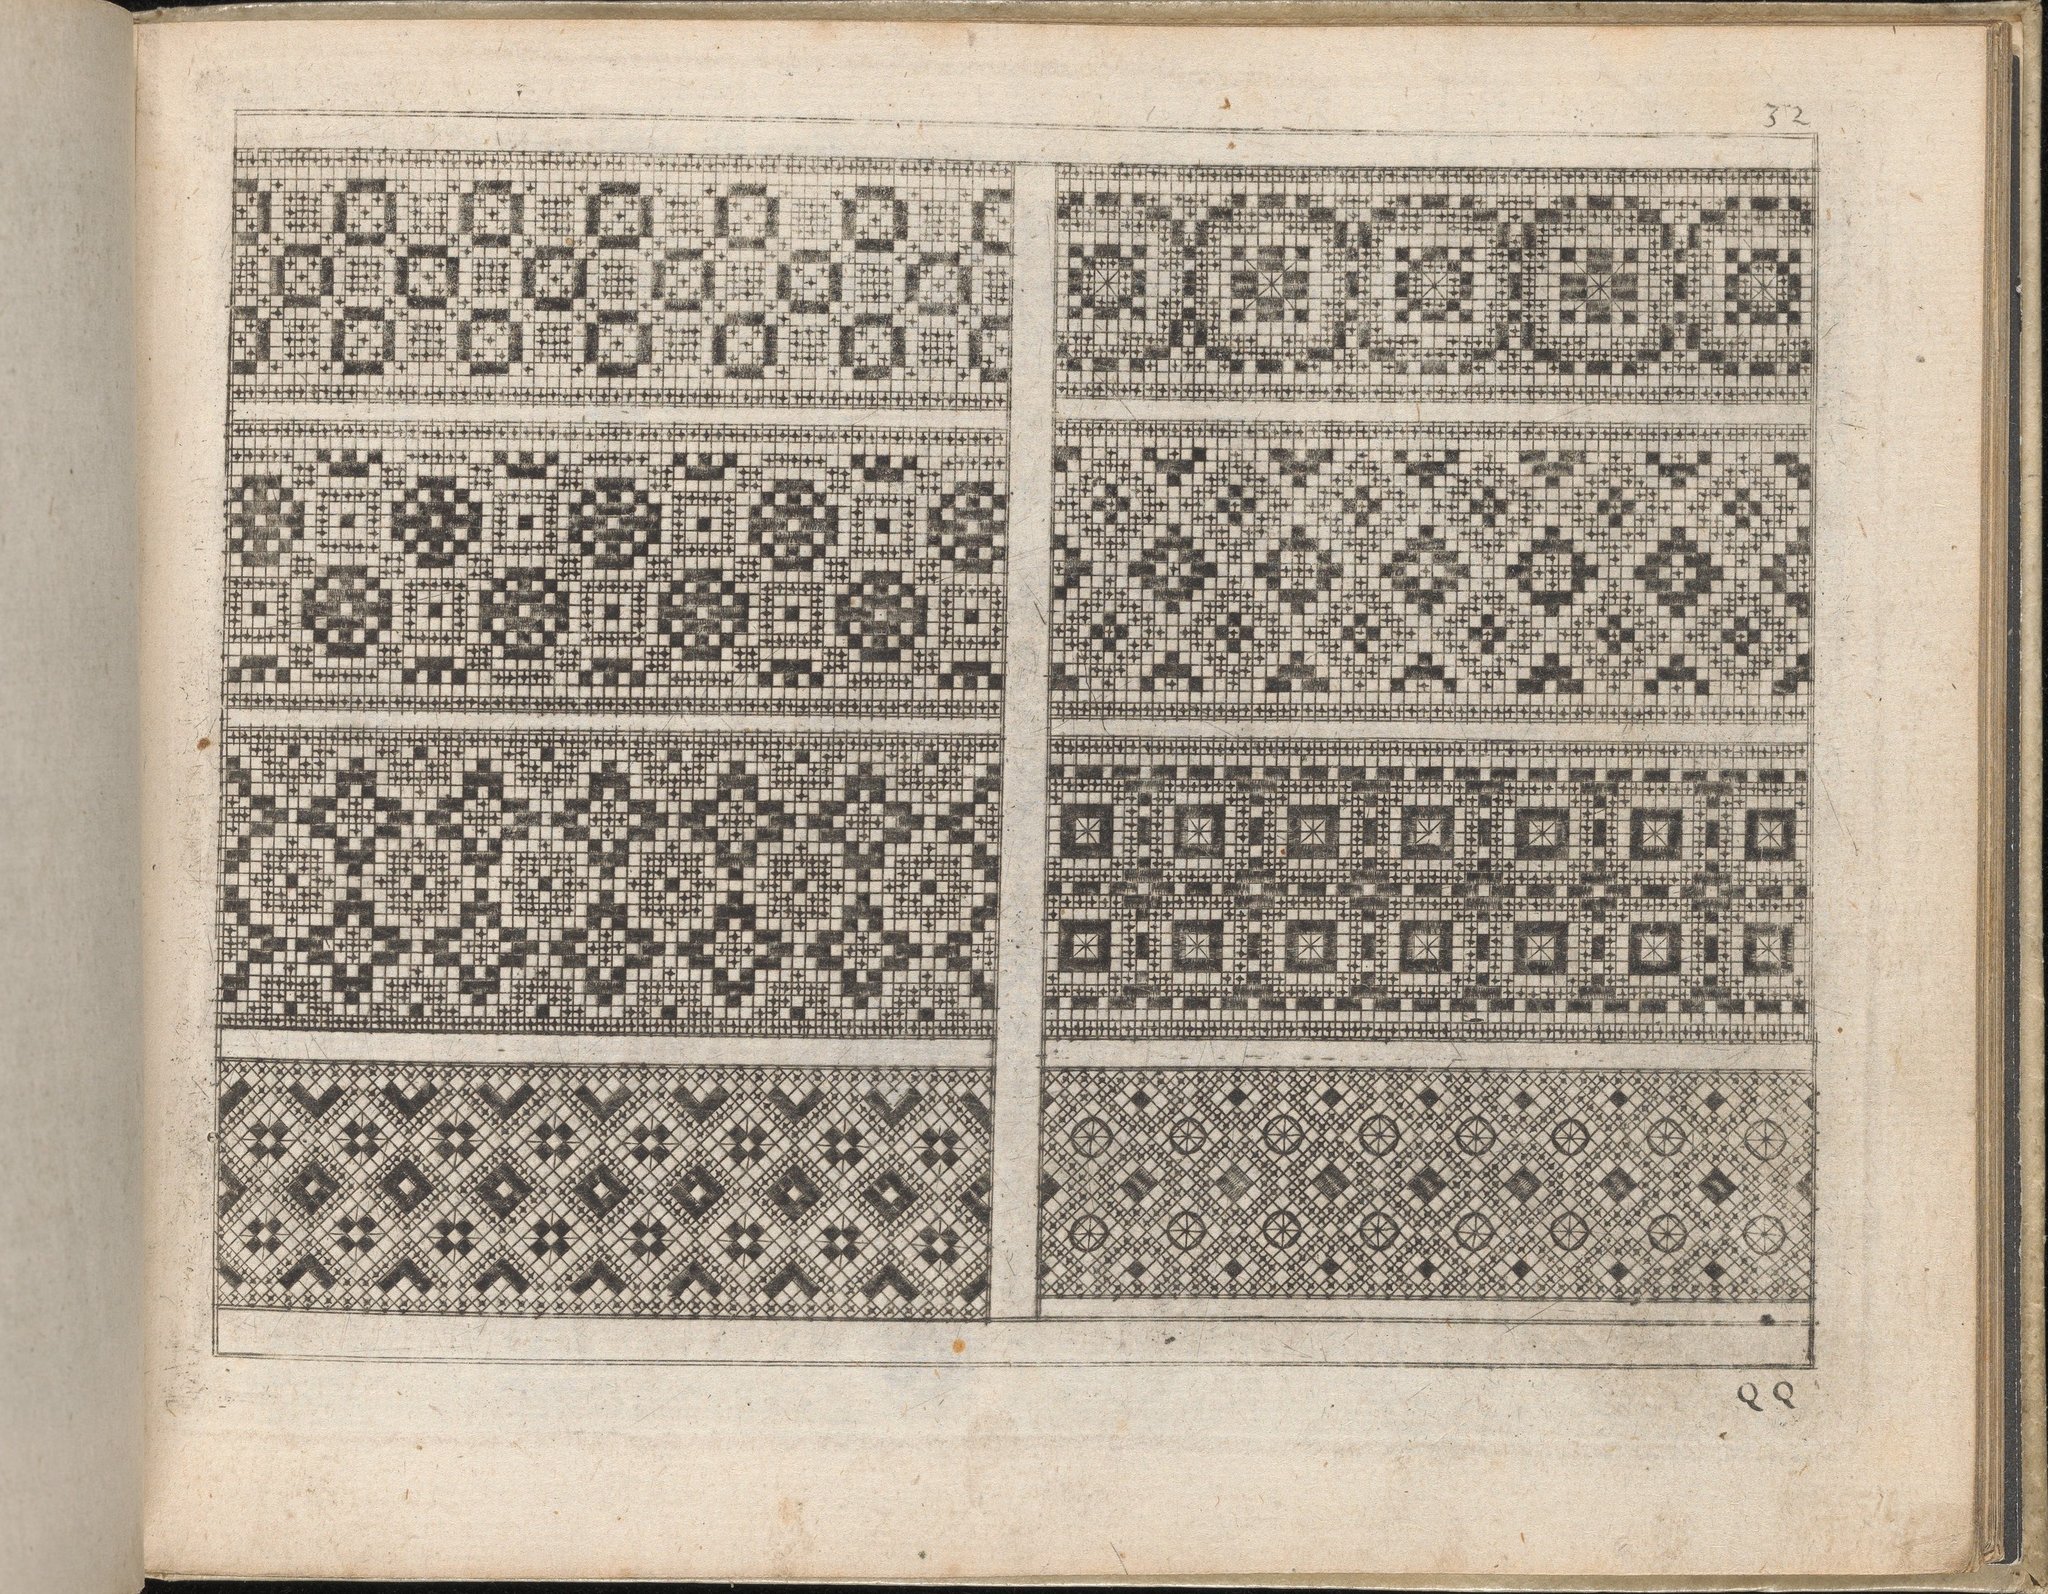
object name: book print ornament architecture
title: Newes Modelbuch in Kupffer (Page 40r)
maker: johann sibmacher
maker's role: artist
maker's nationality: german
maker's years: 1590-1611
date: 1604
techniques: etching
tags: ornament